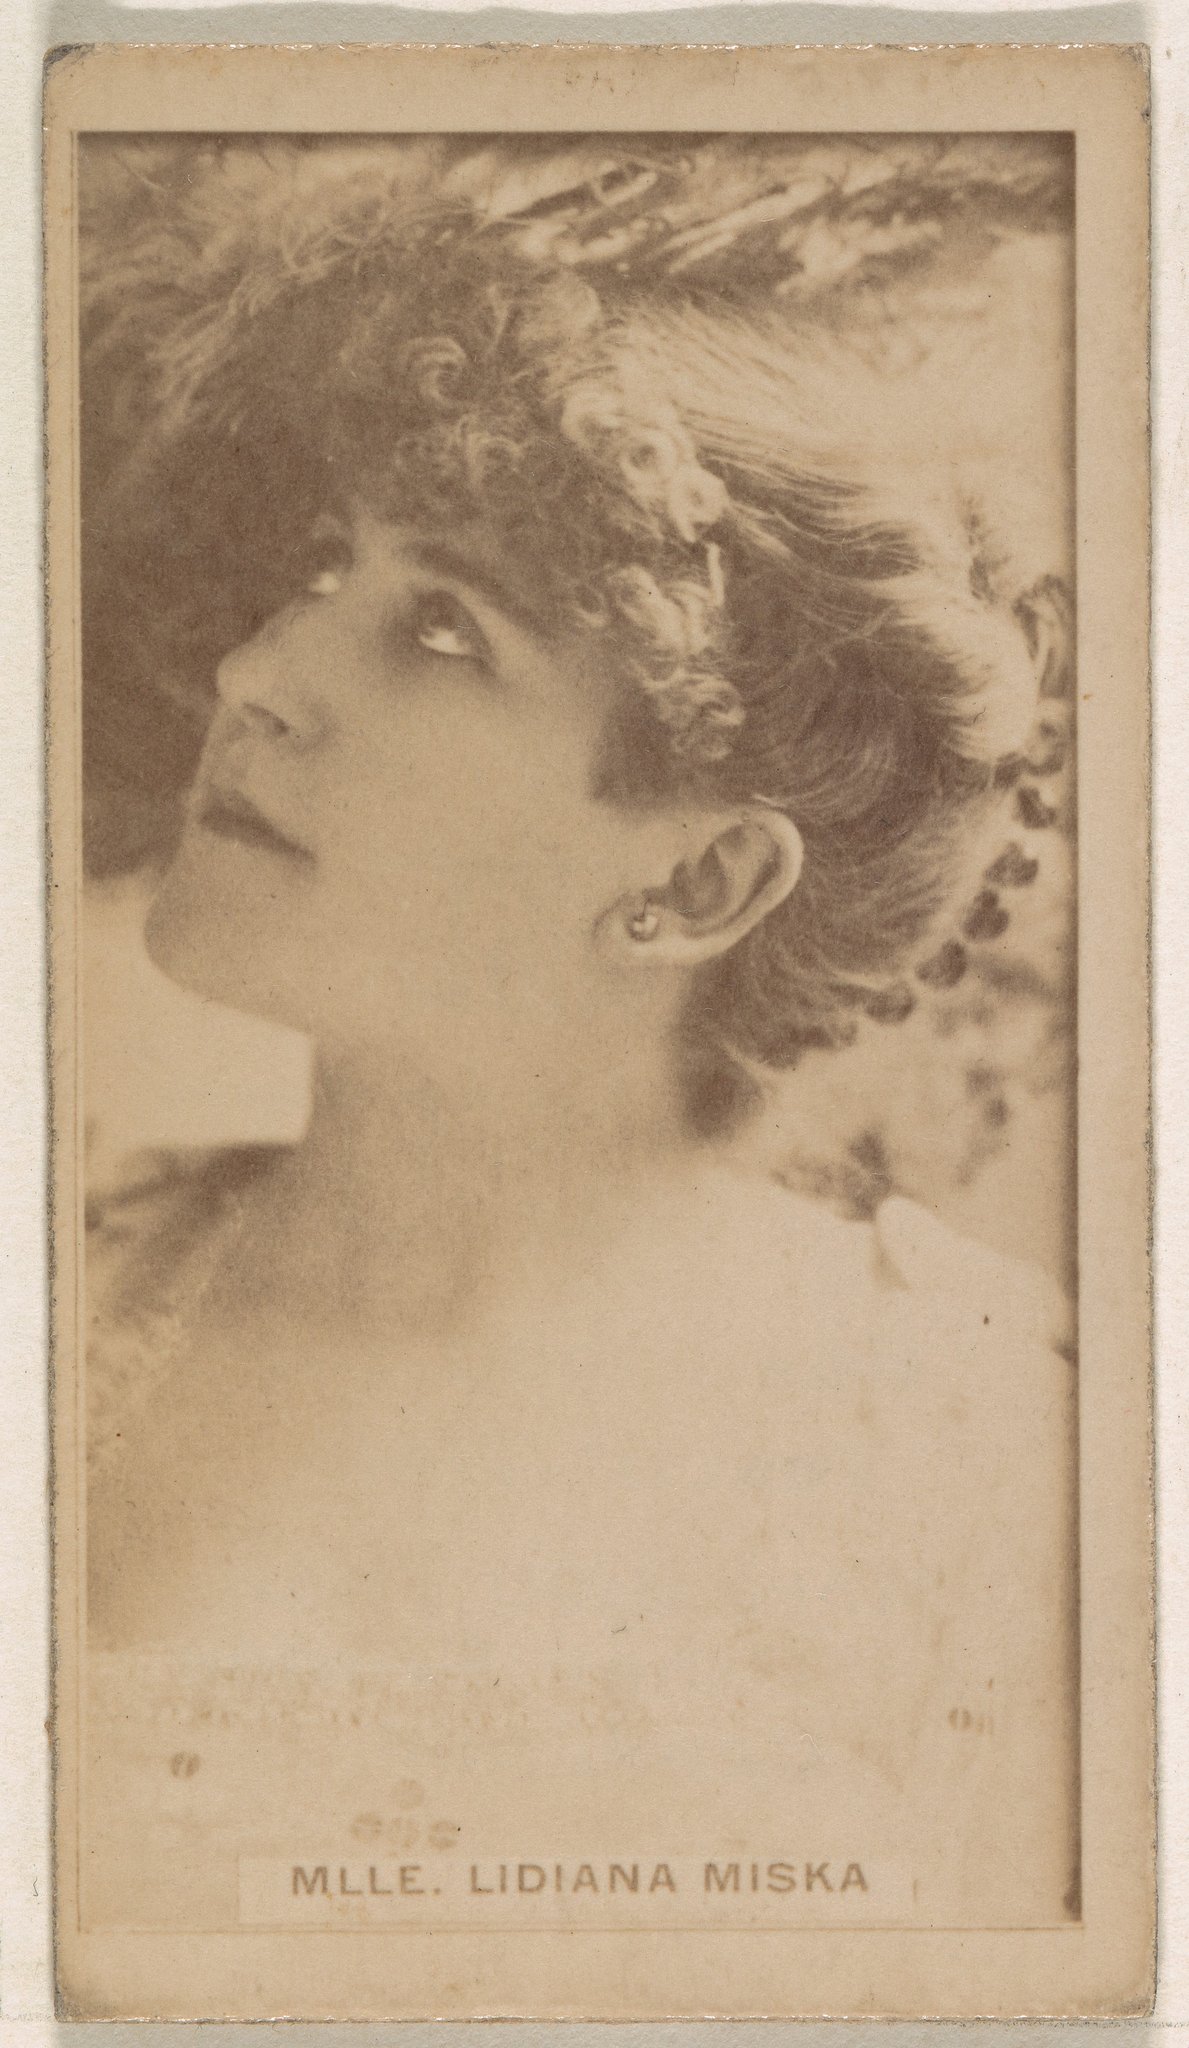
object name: photograph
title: Mlle. Lidiana Miska, from the Actresses series (N245) issued by Kinney Brothers to promote Sweet Caporal Cigarettes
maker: kinney brothers tobacco company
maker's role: publisher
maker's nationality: american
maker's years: 1869-2011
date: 1890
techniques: albumen silver print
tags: portraits,women,actresses